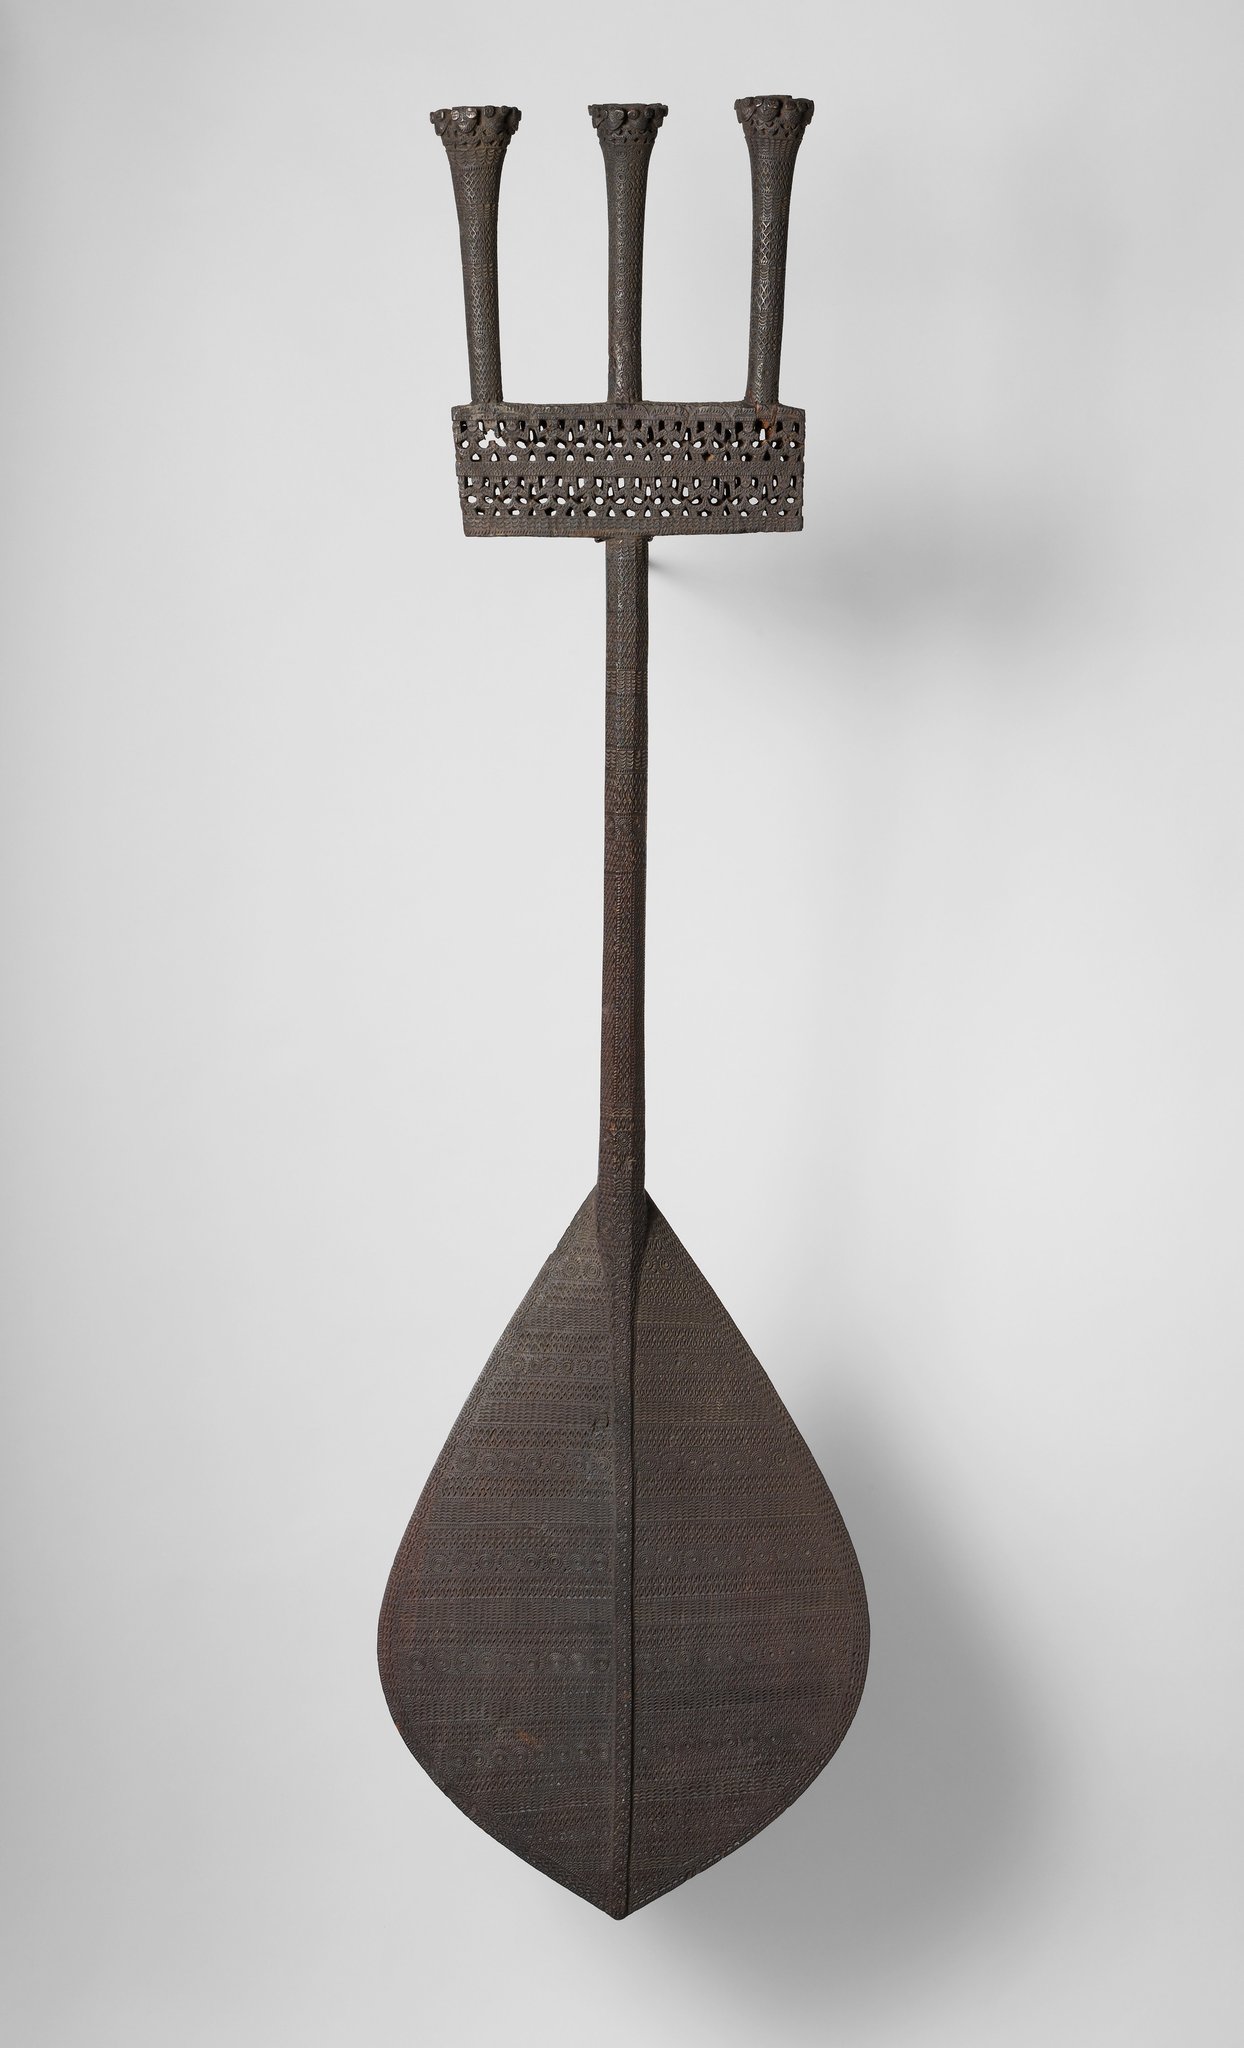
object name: dance paddle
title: Dance Paddle (?)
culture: austral islanders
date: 1820-1840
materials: wood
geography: french polynesia